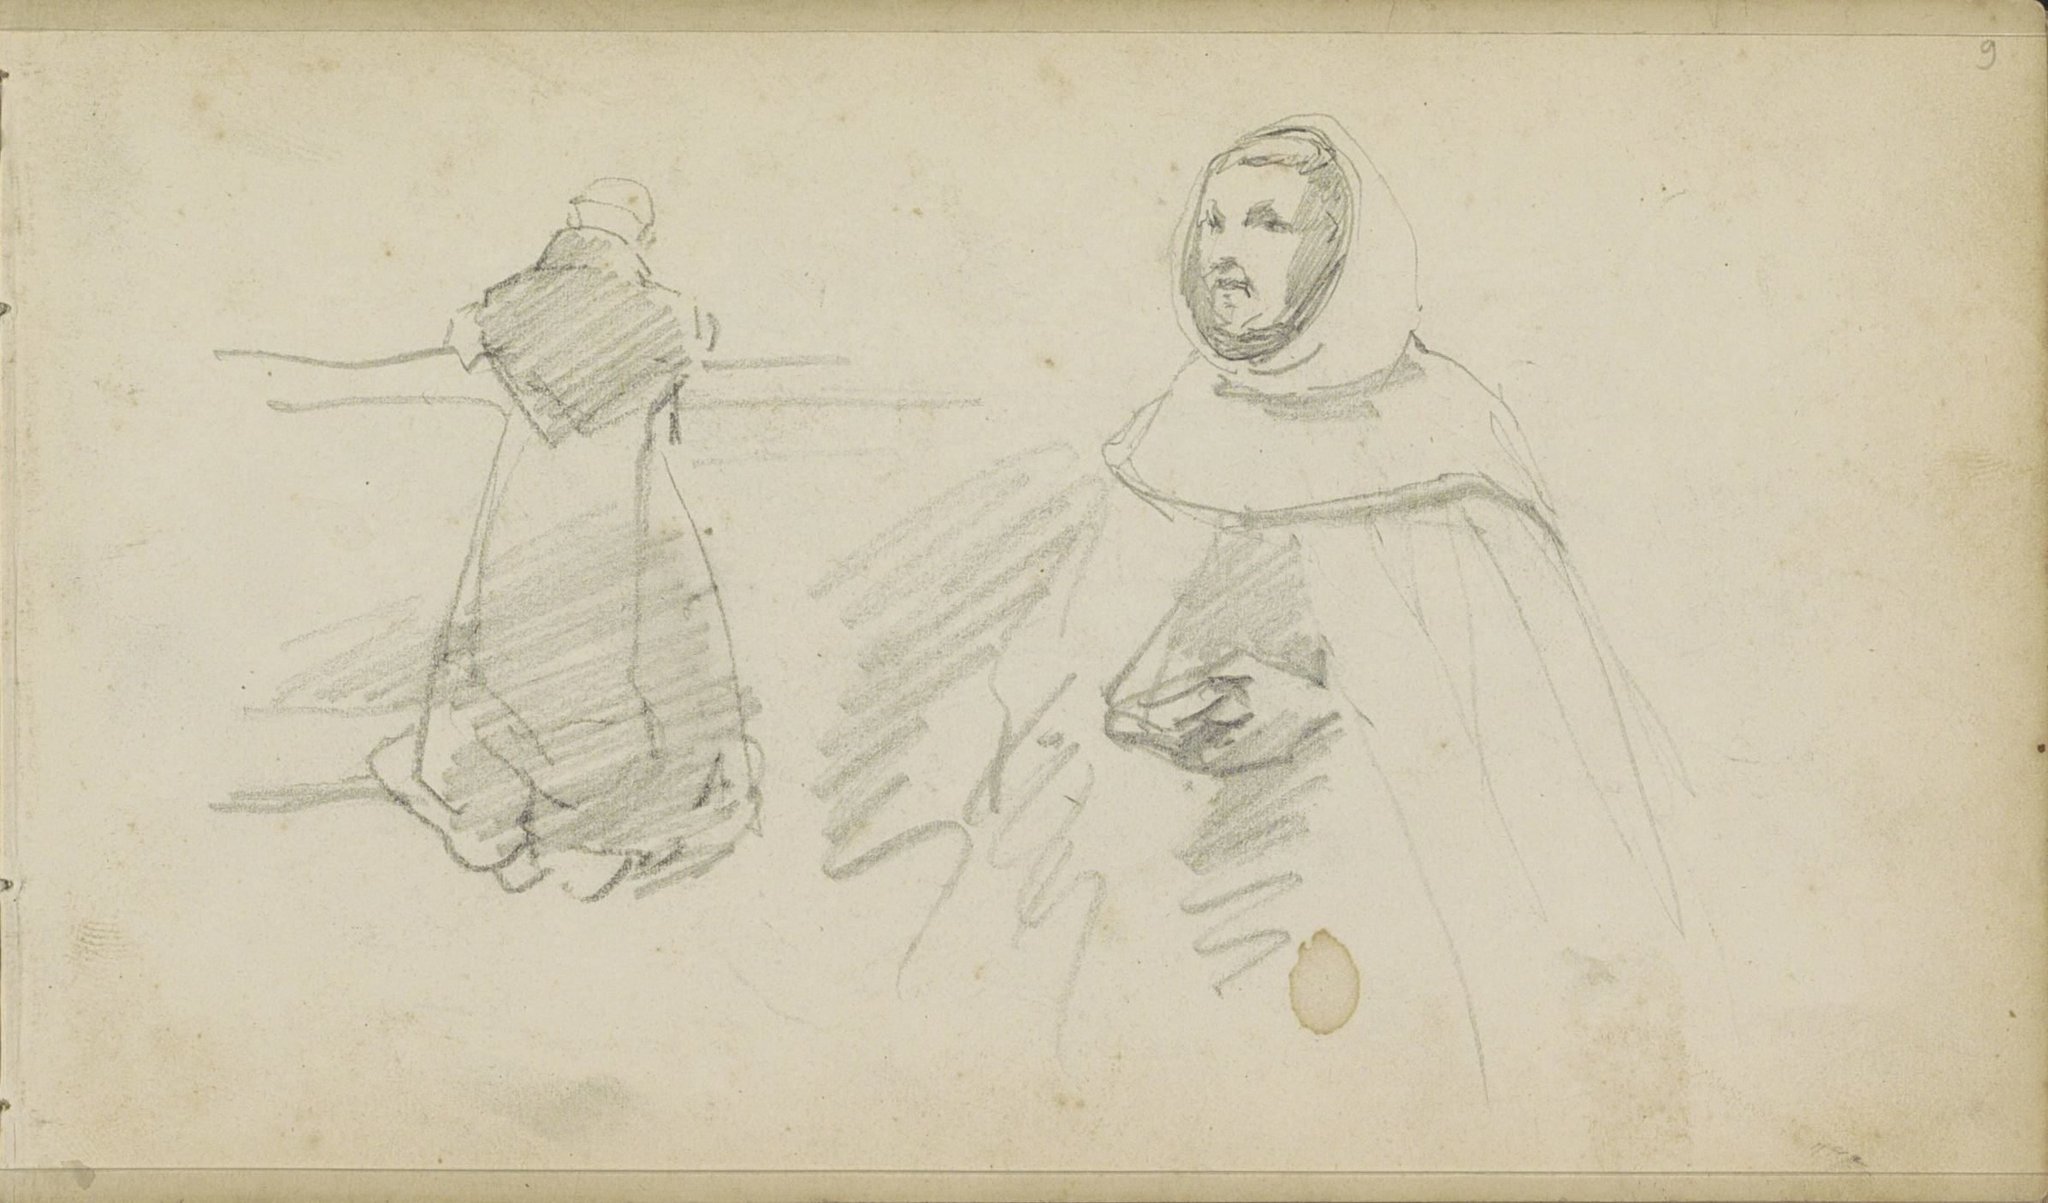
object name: sketchbook leaf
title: Monnik leunend op een muur en een monnik met ineengevouwen handen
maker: johannes bosboom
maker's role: draughtsman, painter, print maker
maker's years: 1817-1891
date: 1845-1891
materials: paper, pencil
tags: monk(s), friar(s)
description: Blad 9 recto uit een schetsboek met 46 bladen.